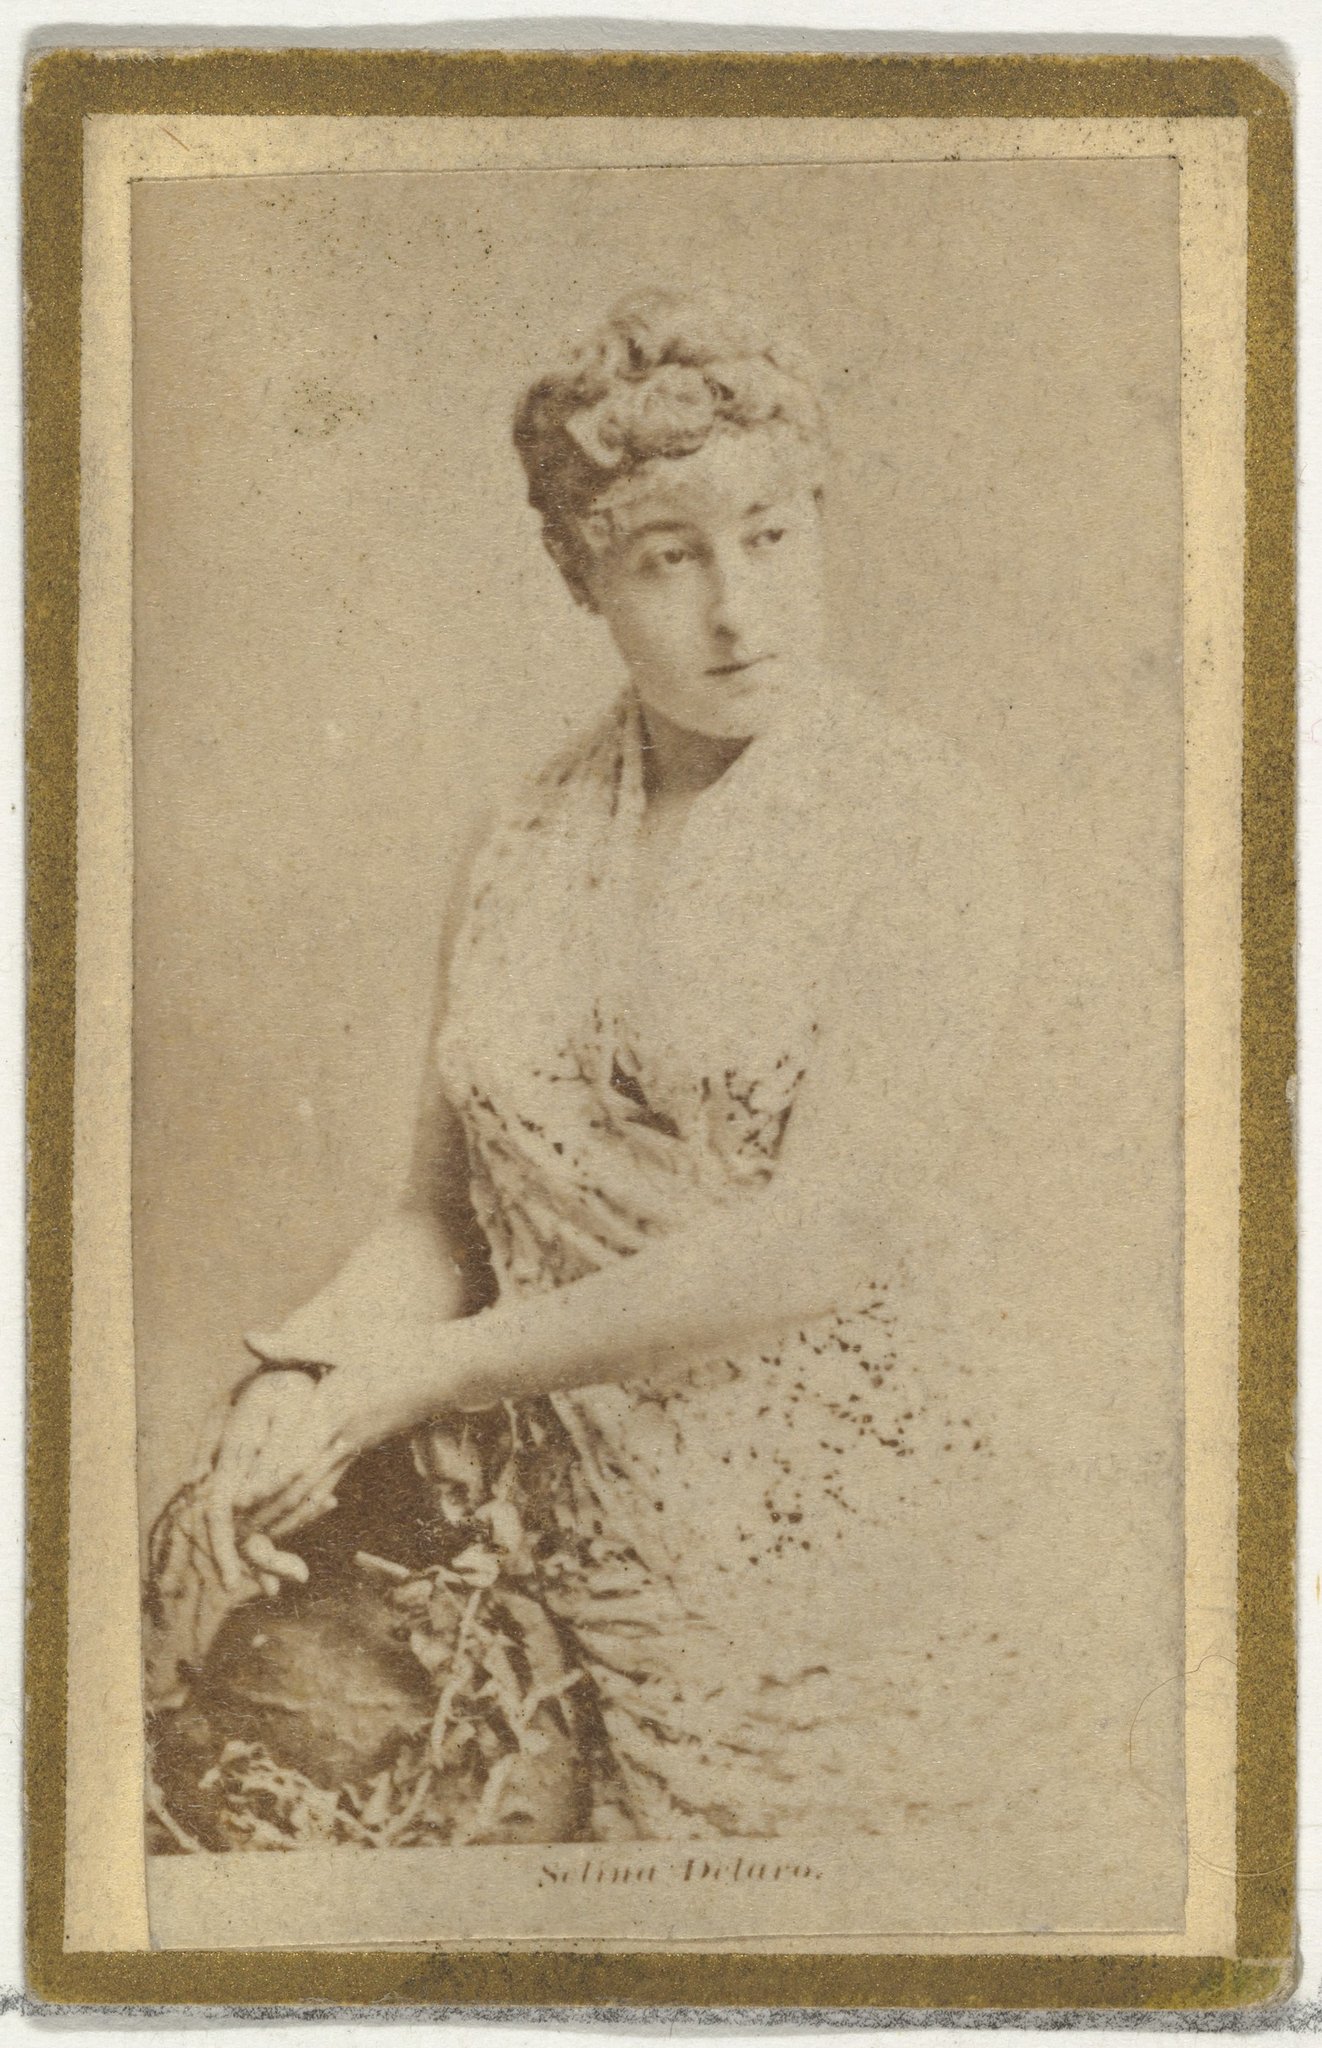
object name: photograph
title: Selina Delaro, from the Actresses and Celebrities series (N60, Type 2) promoting Little Beauties Cigarettes for Allen & Ginter brand tobacco products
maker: allen & ginter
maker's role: publisher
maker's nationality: american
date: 1887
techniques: albumen silver print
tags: portraits,women,actresses